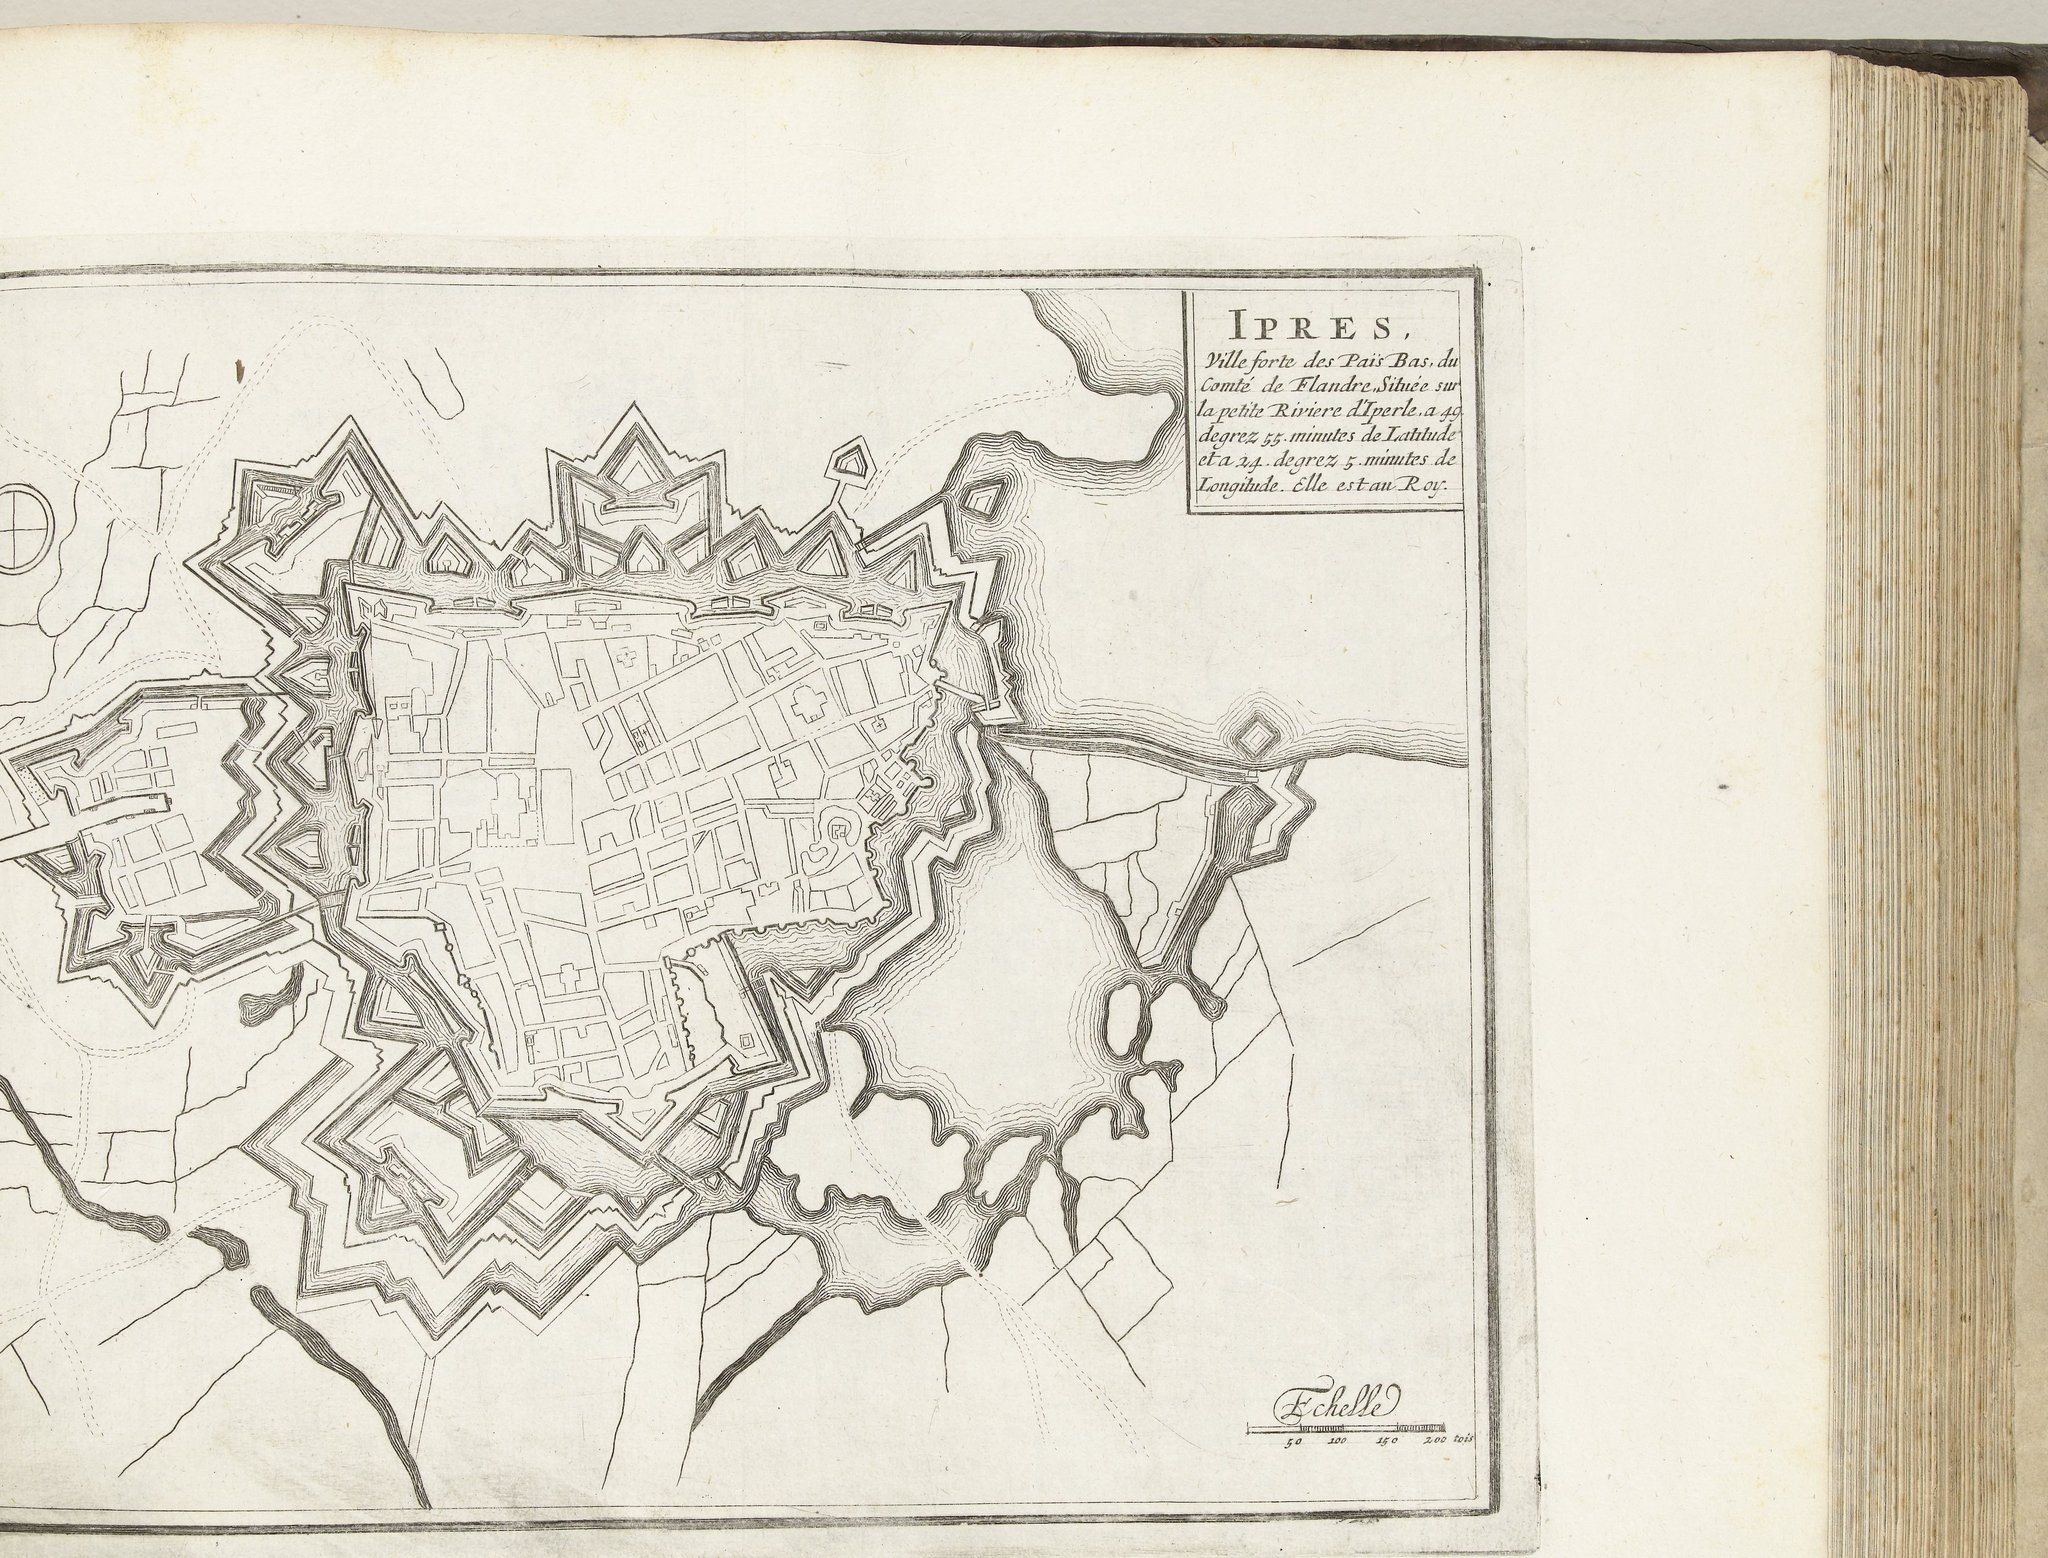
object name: map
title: Ipres, Ville forte des Pais Bas, du Comté de Flandre (...)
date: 1693-1696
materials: paper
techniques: etching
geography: paris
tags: fortress, maps of cities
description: Plattegrond van de versterkingen om de Vlaamse stad Yperen. Onderdeel van het zevende deel (1696) van het prentwerk waarin gebundeld zijn de acht delen van Les forces de l'Europe uitgegeven tussen 1693-1697. Het prentwerk bestaat uit 175 platen met plannen (afkomstig van Sébastien Le Prestre, Seigneur de Vauban) van vermaarde sterke steden en vestingen in de Negenjarige Oorlog. Titel en opschriften in het Frans.